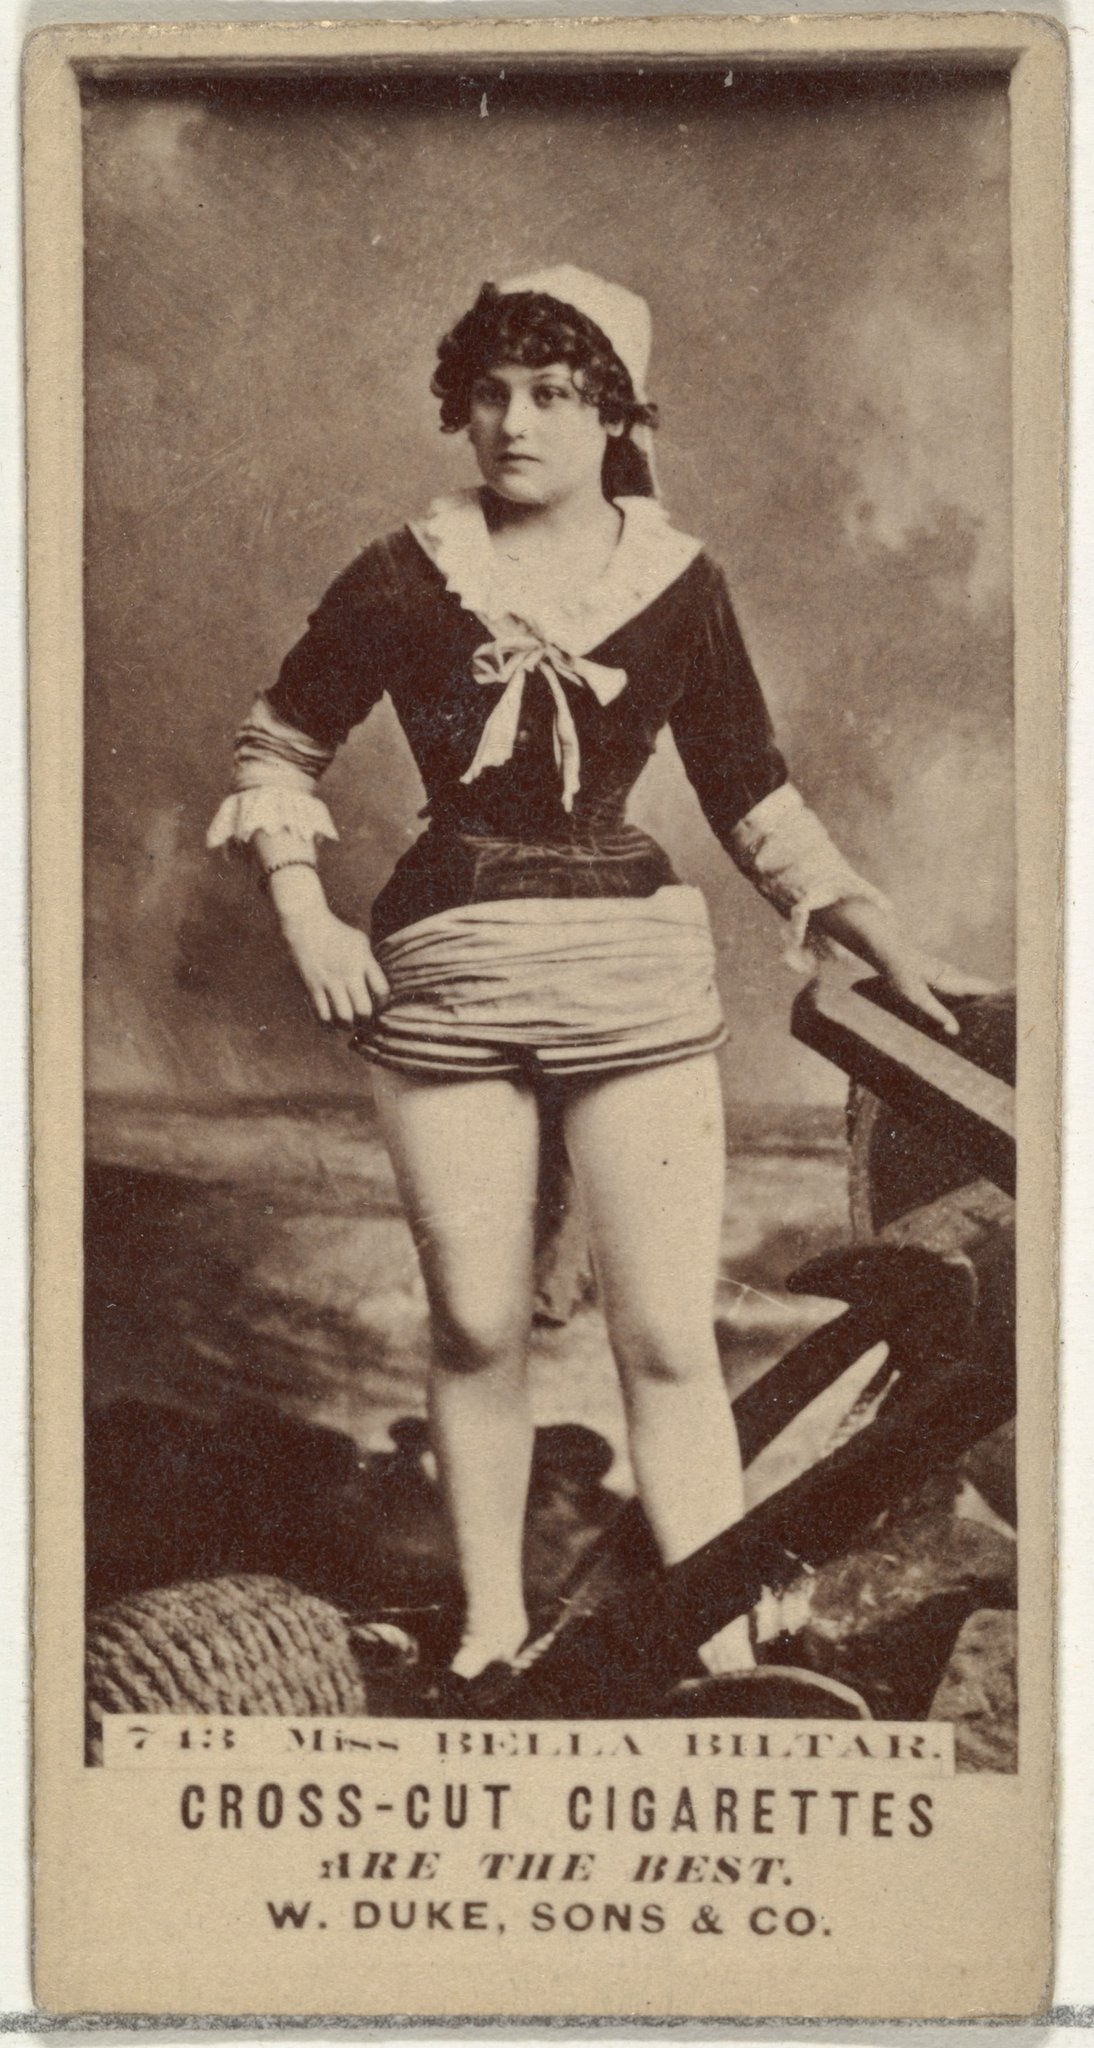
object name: photograph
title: Card Number 743, Miss Bella Biltar, from the Actors and Actresses series (N145-3) issued by Duke Sons & Co. to promote Cross Cut Cigarettes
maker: w. duke, sons & co.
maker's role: publisher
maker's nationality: american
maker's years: 1870-1920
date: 1880-1889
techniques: albumen silver print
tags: portraits,women,actresses